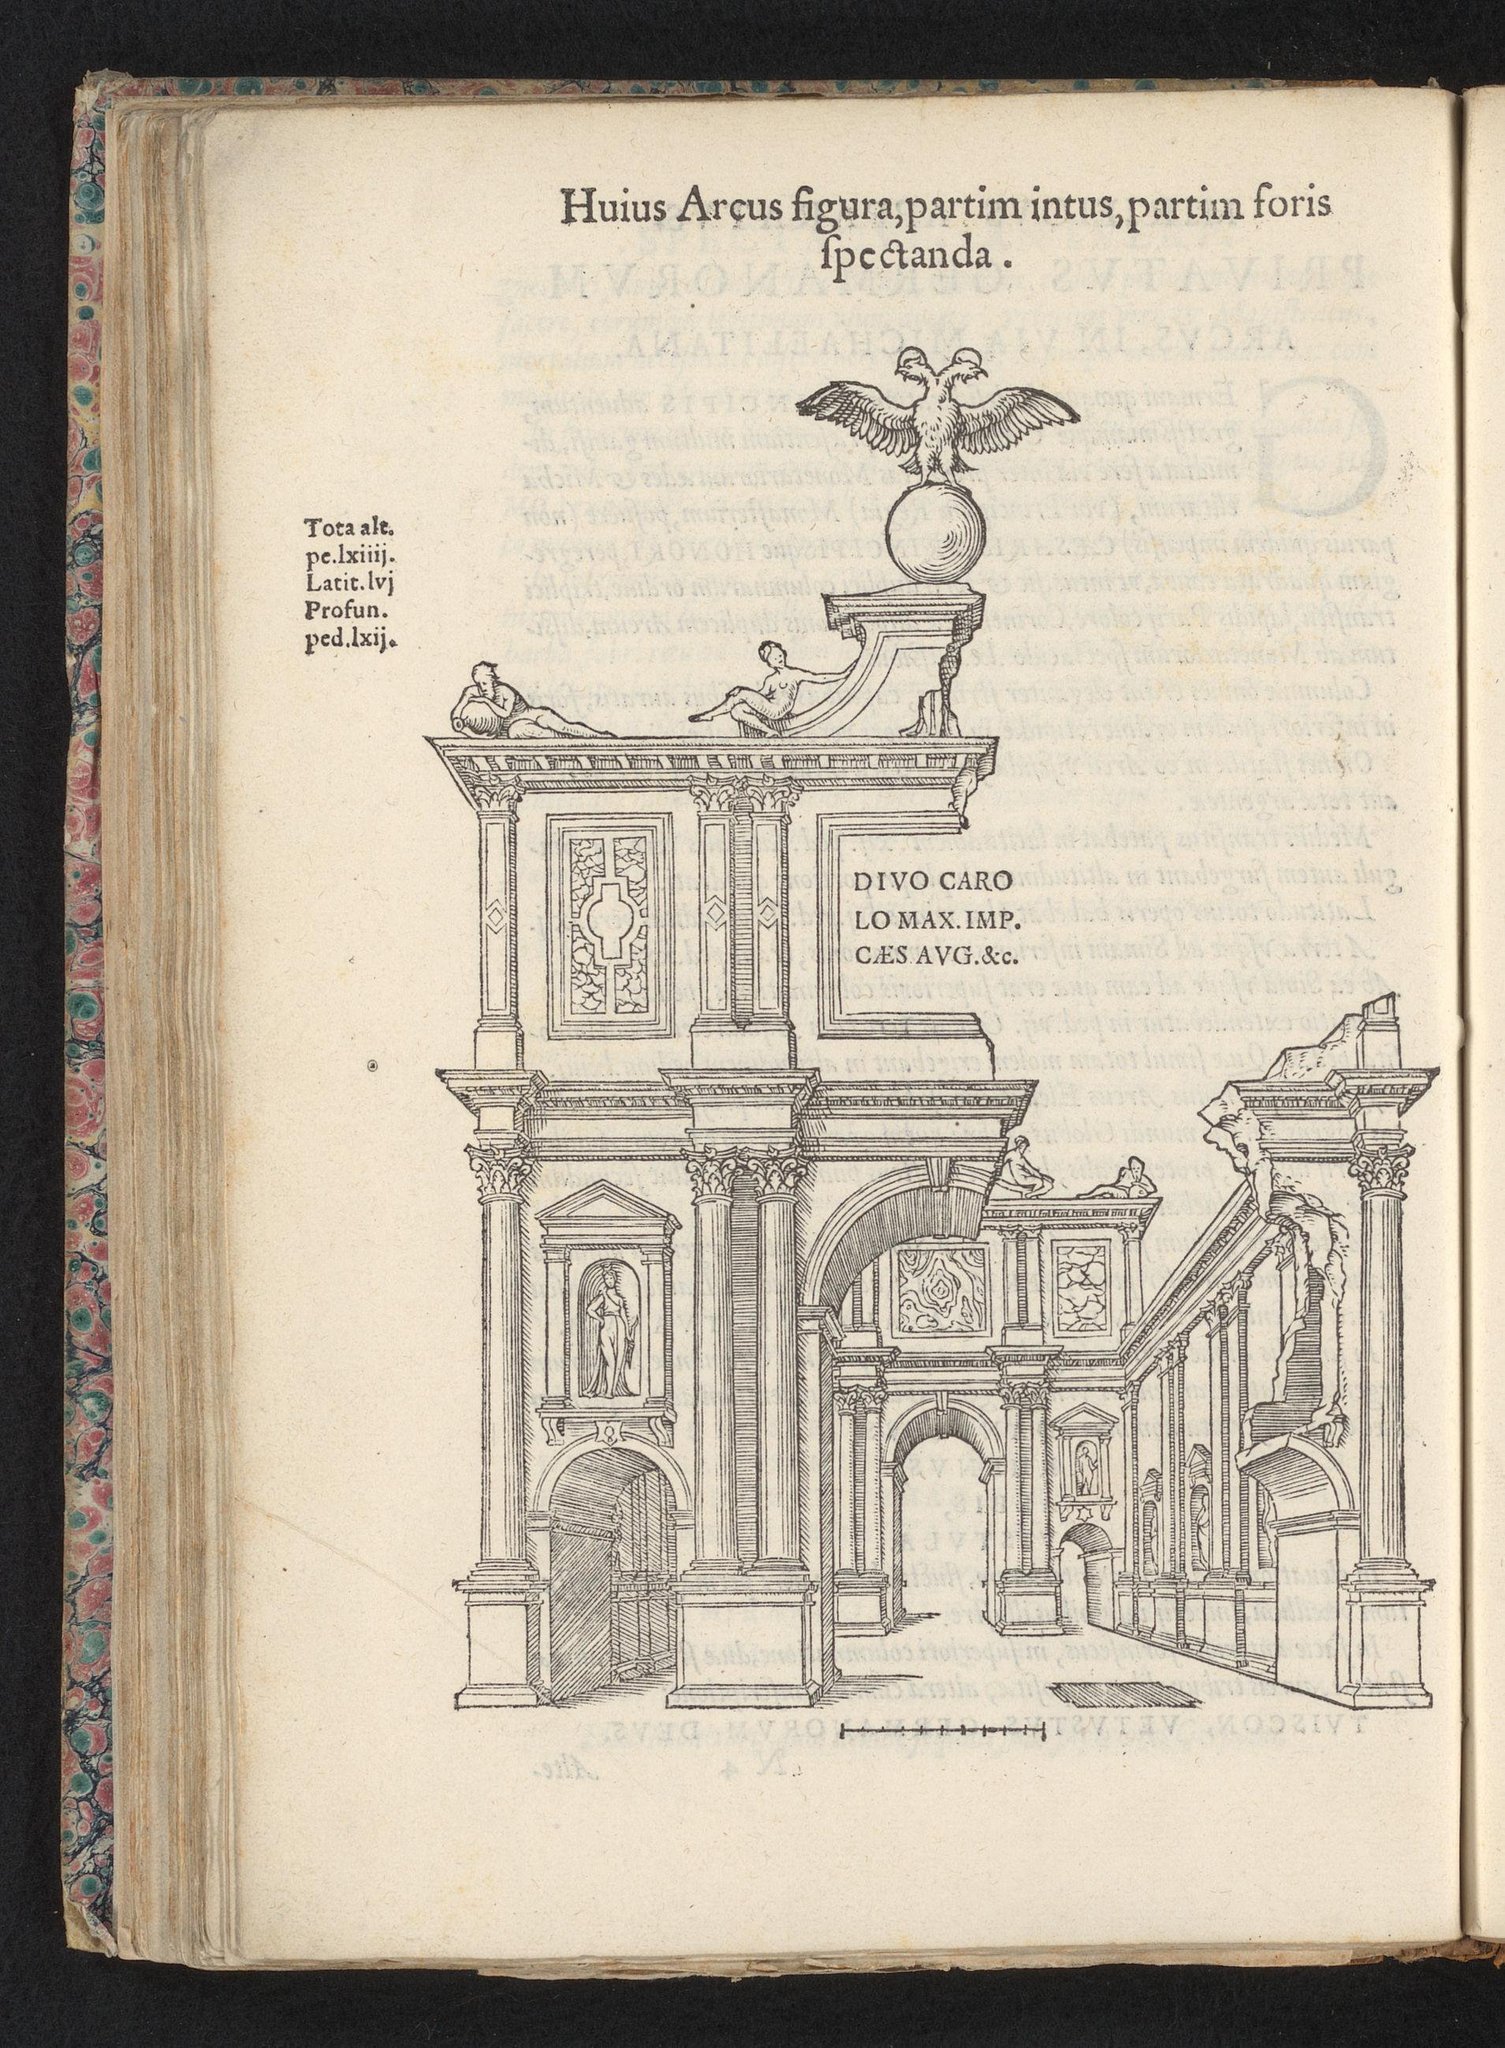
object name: print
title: Huius Arcus figura, partim intus, partim foris spectanda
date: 1549-1550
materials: paper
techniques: woodcut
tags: philip ii of spain, triumphal arch, antwerp, germany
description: Illustratie in: Spectaculorum in susceptione Philippi Hisp. Prin. Divi Caroli. V. Caes. F. ann 1549 Antverpiae aeditorum, mirificus apparatus. Tekst van Cornelius Grapheus, opgedragen aan Filips II, uitgegeven met keizerlijke privilege door Pieter Coecke van Aelst, gedrukt door Gillis van Diest. Boek in de bibliotheek met signatuur: 325 B 13.